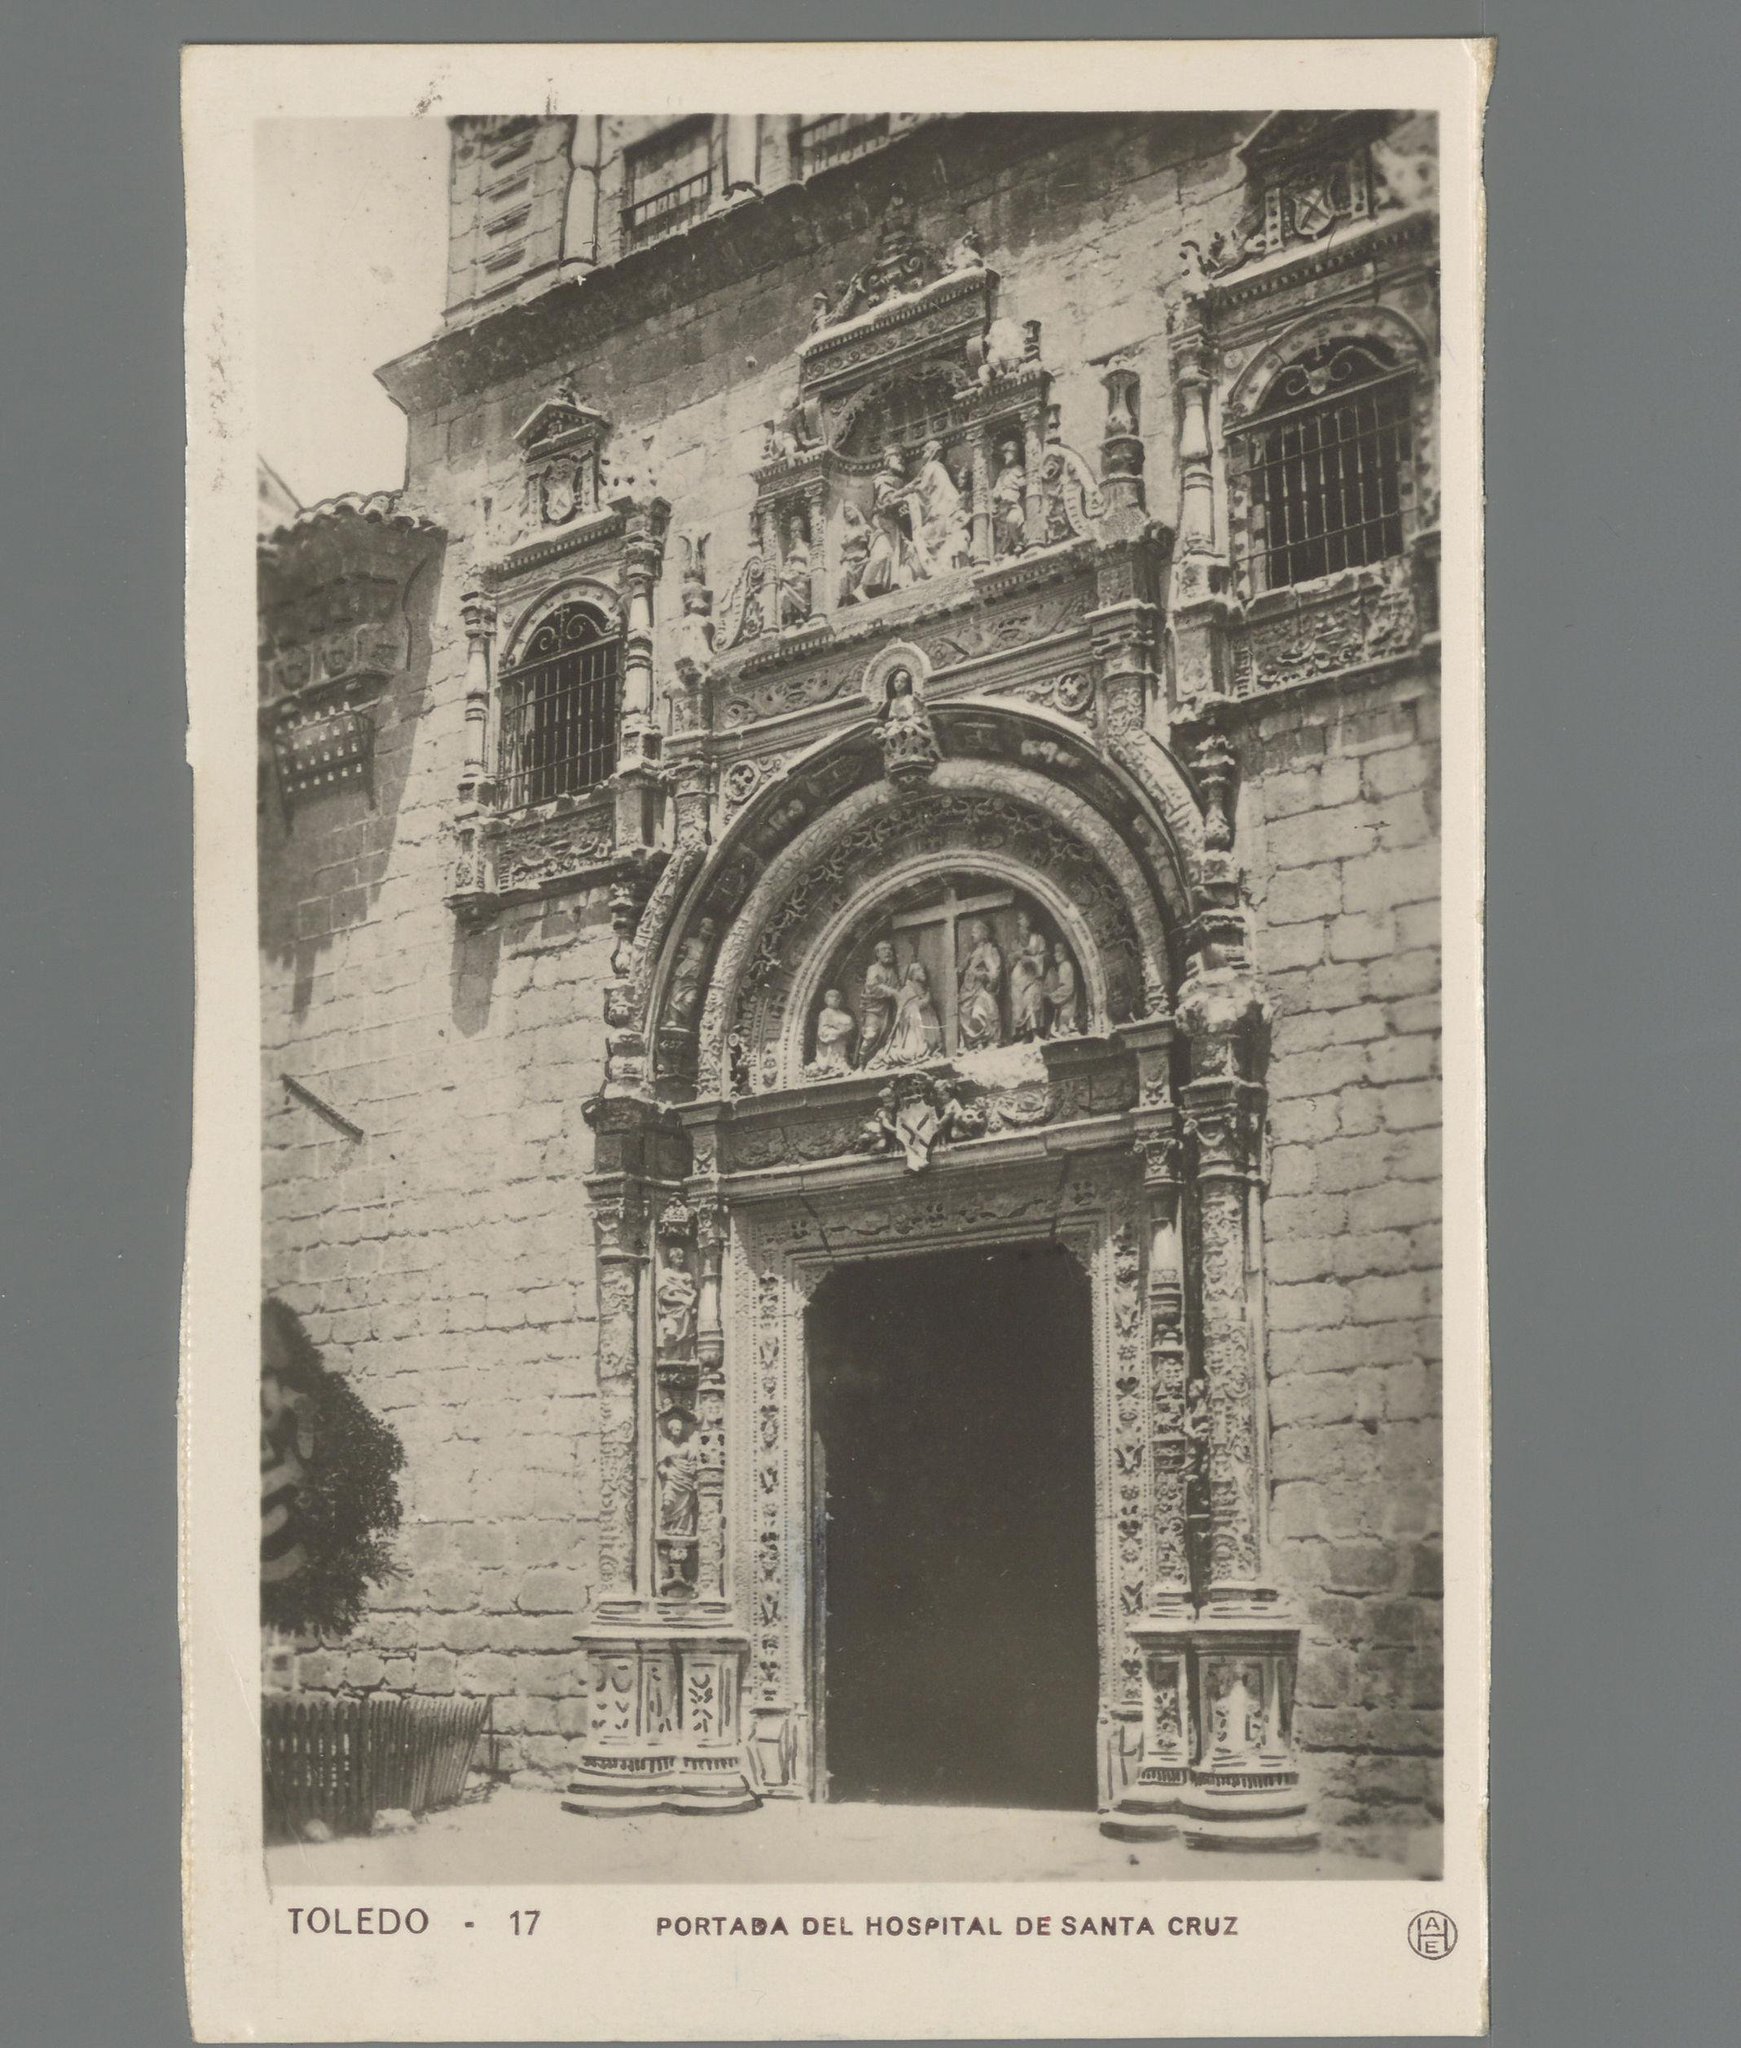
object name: ansichtkaart, prentbriefkaart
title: Toledo - Portada del hospital de Santa Cruz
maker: Anonymous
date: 1930-1939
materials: paper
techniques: gelatin silver print, writing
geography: madrid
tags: gate, entrance, hospital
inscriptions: postage stamp